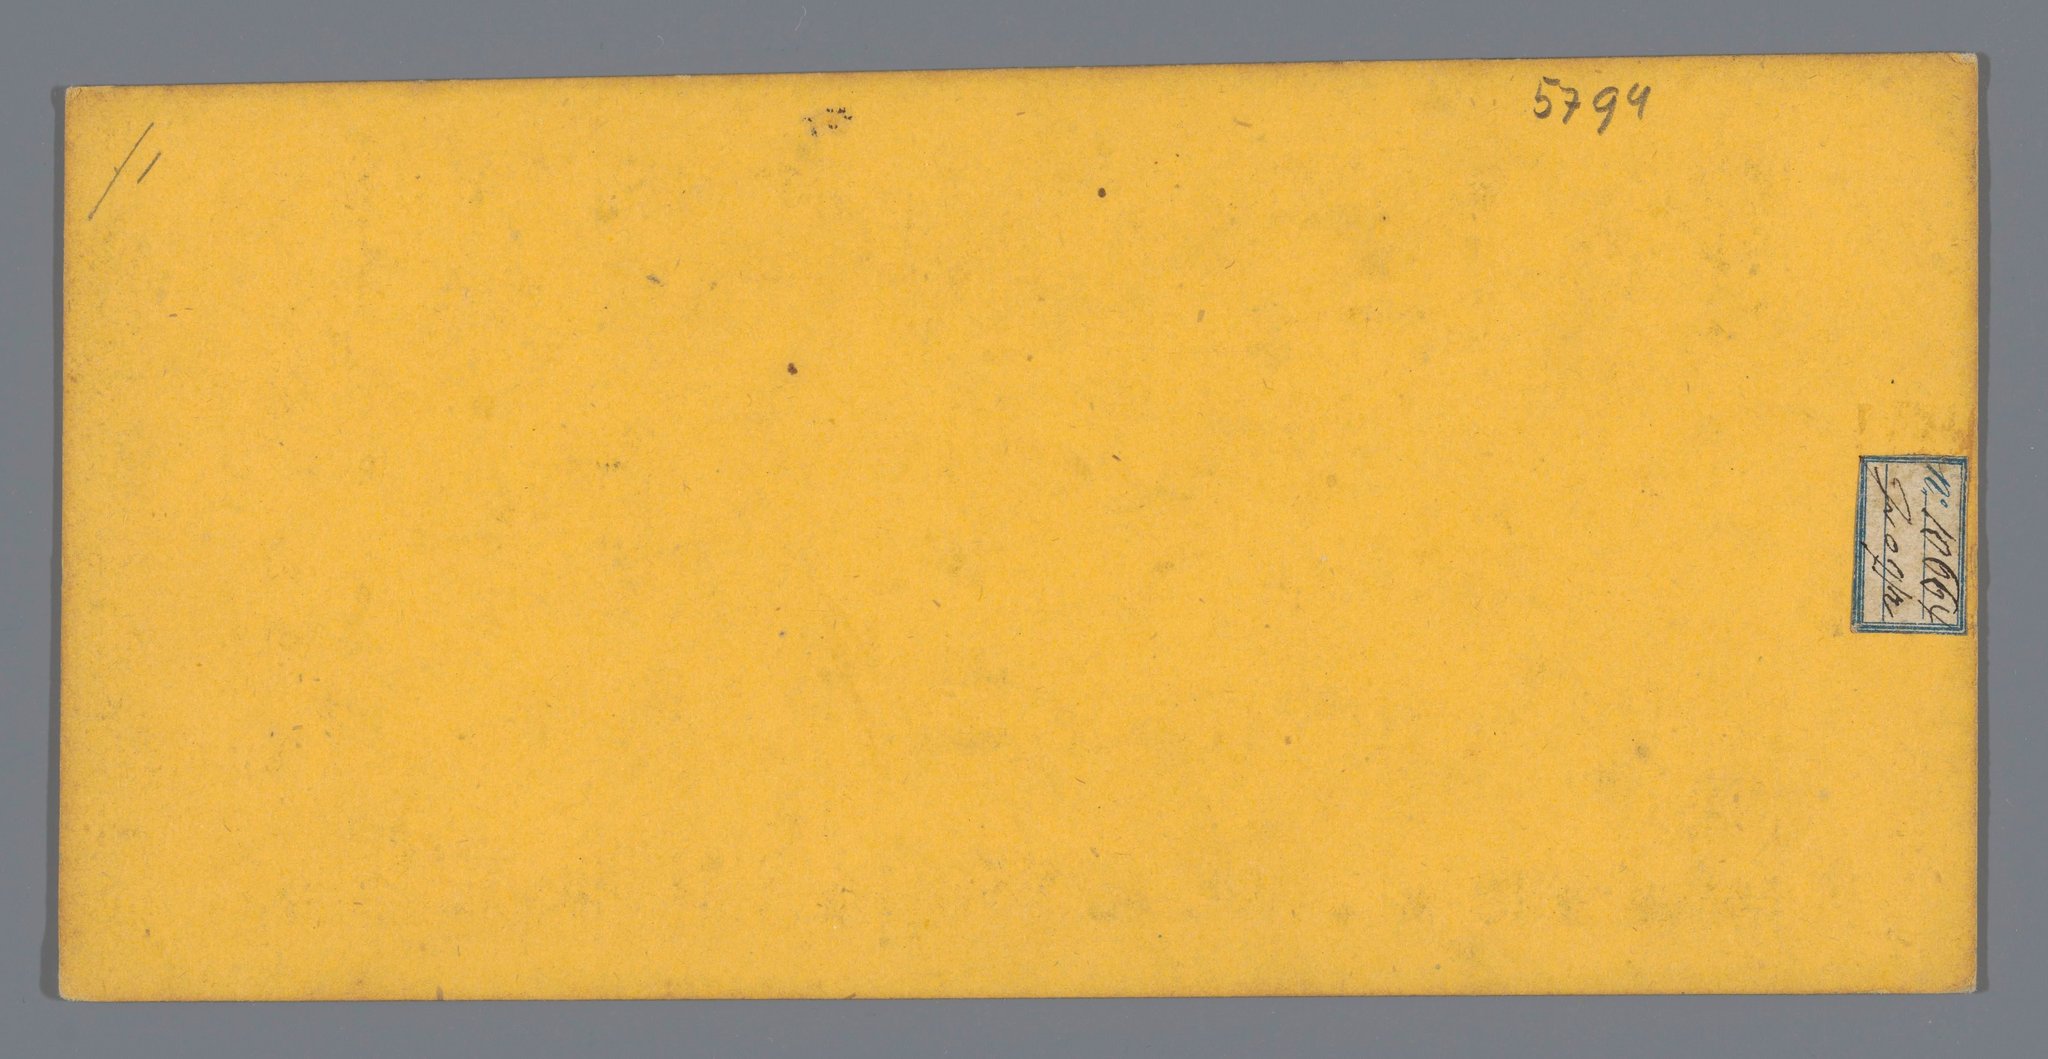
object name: stereograph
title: Gezicht op het Pavillon Turgot van het Musée du Louvre in Parijs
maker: Anonymous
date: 1850-1870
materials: cardboard, photographic support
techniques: albumen print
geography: paris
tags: permanent exhibition, museum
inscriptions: number: ‘No 10664 [...]’